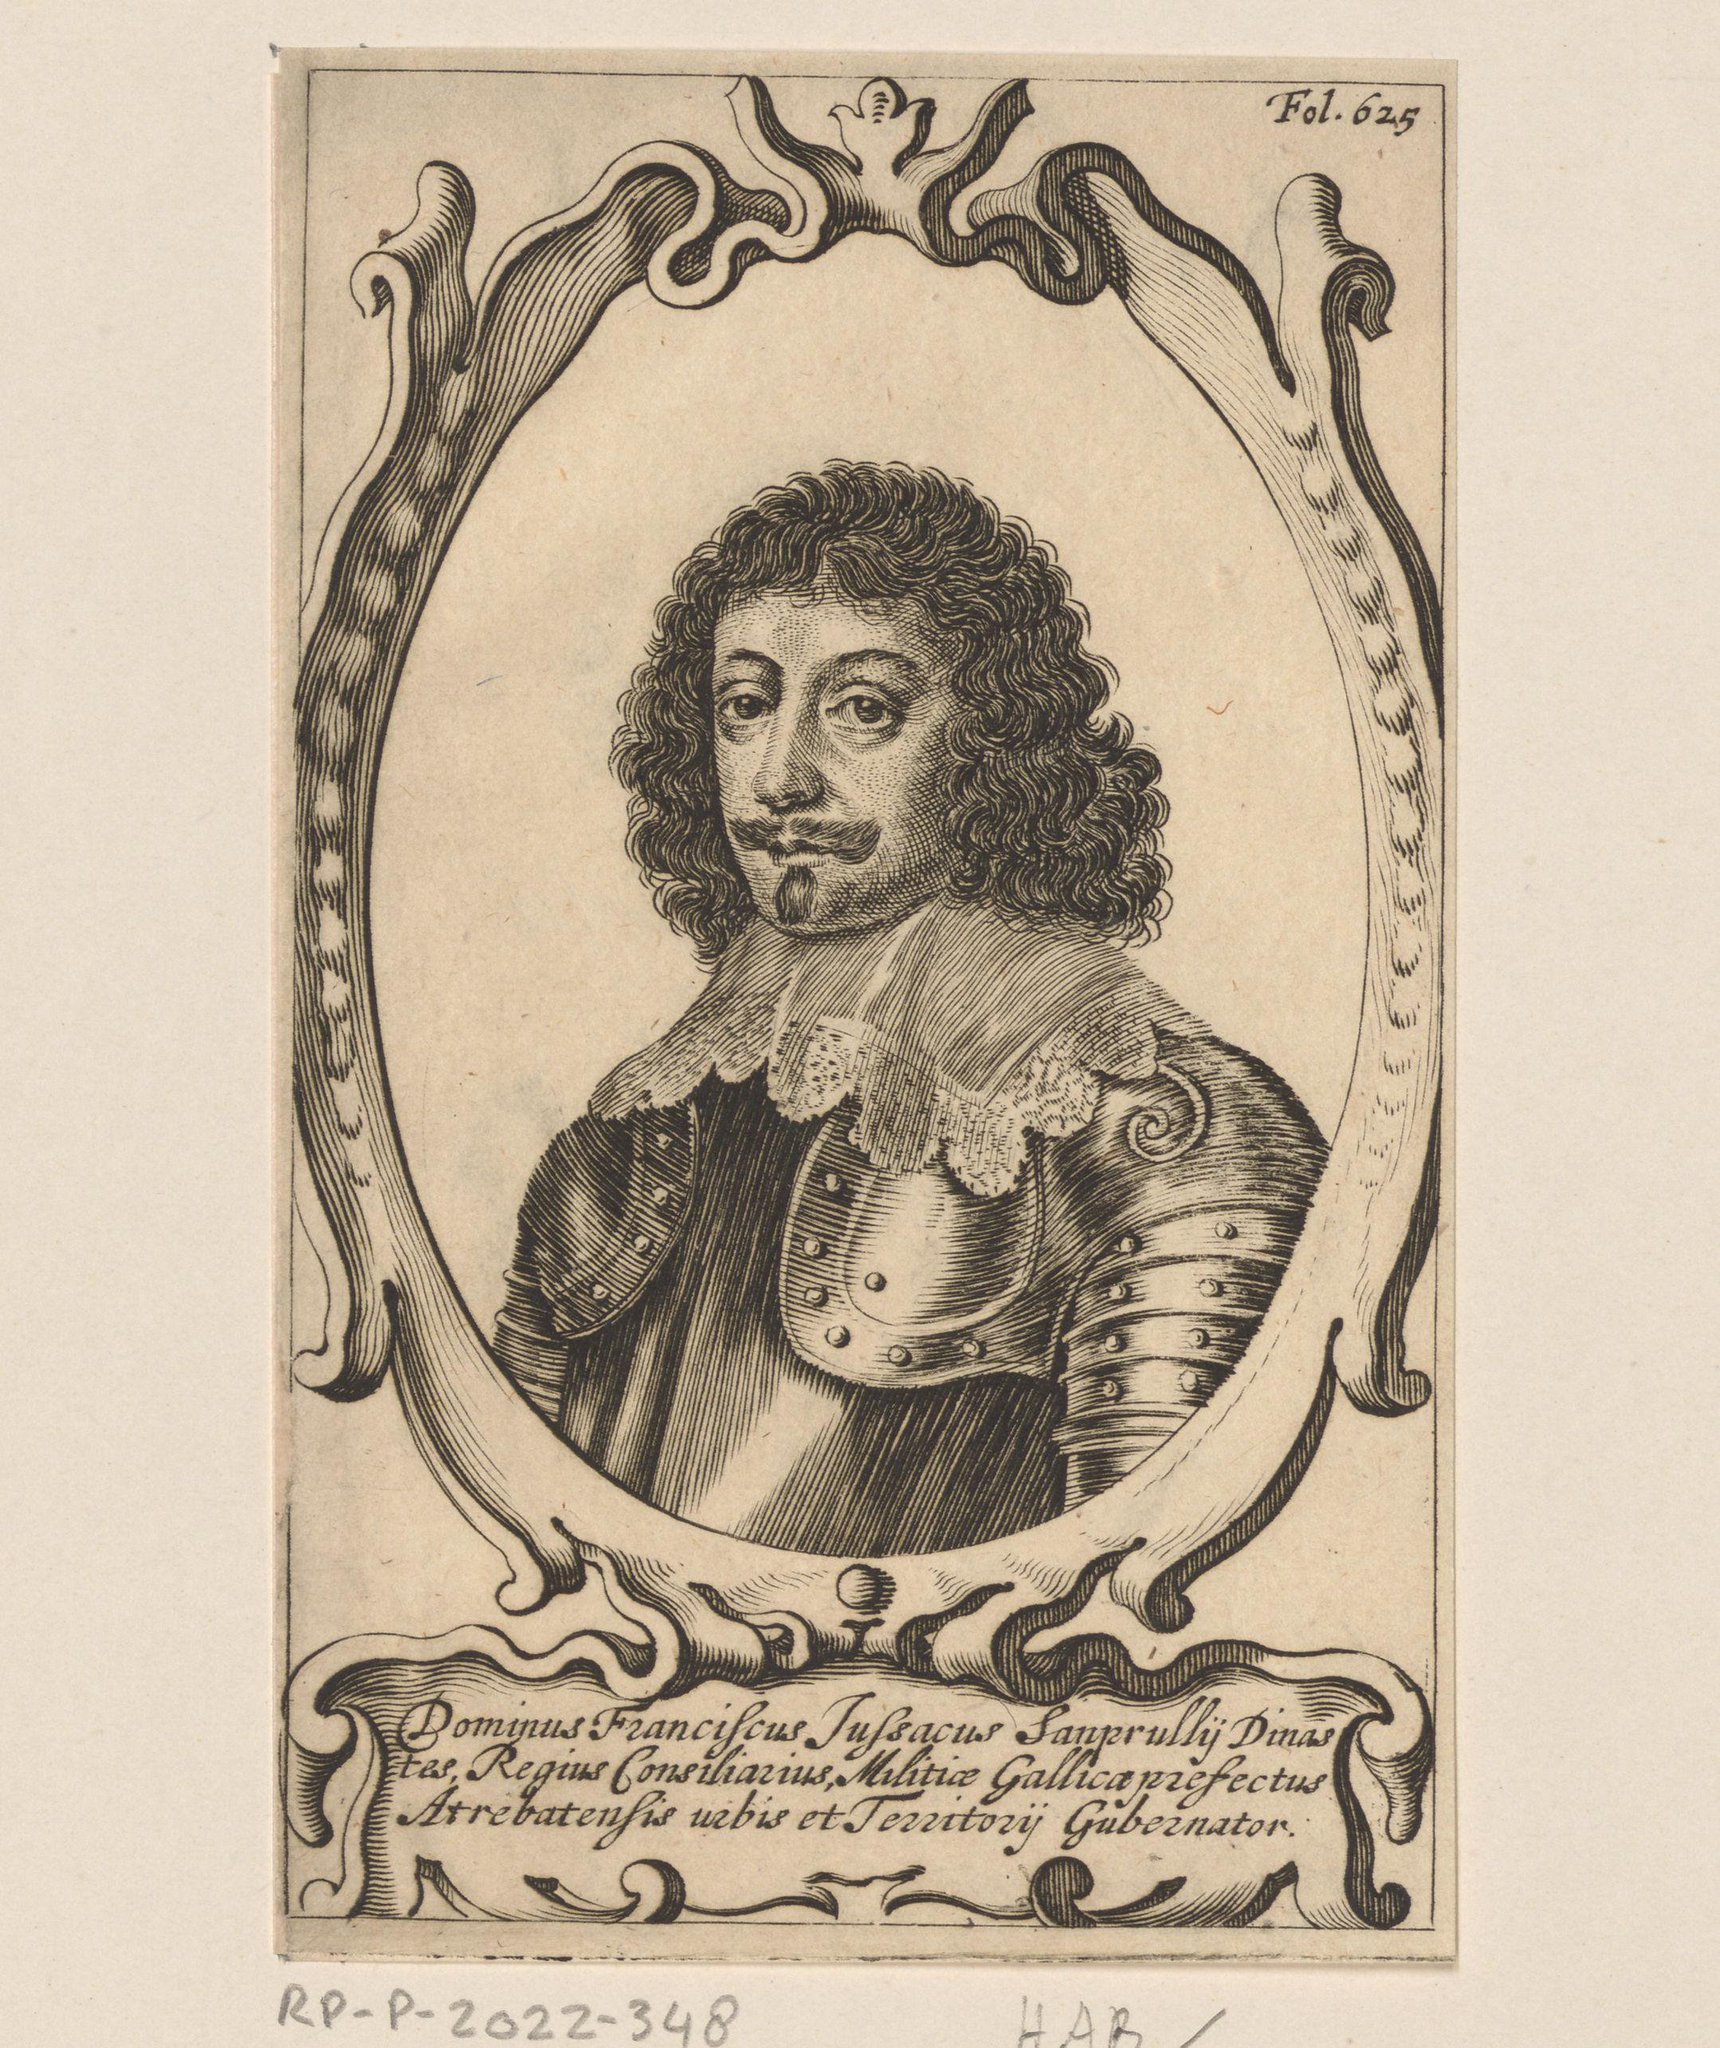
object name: print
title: Portret van François de Jussac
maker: Anonymous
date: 1655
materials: paper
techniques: engraving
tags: historical persons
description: Prent waarschijnlijk uit: Bos, Lambert van den. Het treur-toonneel der doorluchtige mannen onser eeuwe, zijnde het vervolgh van het konincklick en vorstelick treur-toonneel. Rotterdam: Andries van Hoogenhuysen, 1655.